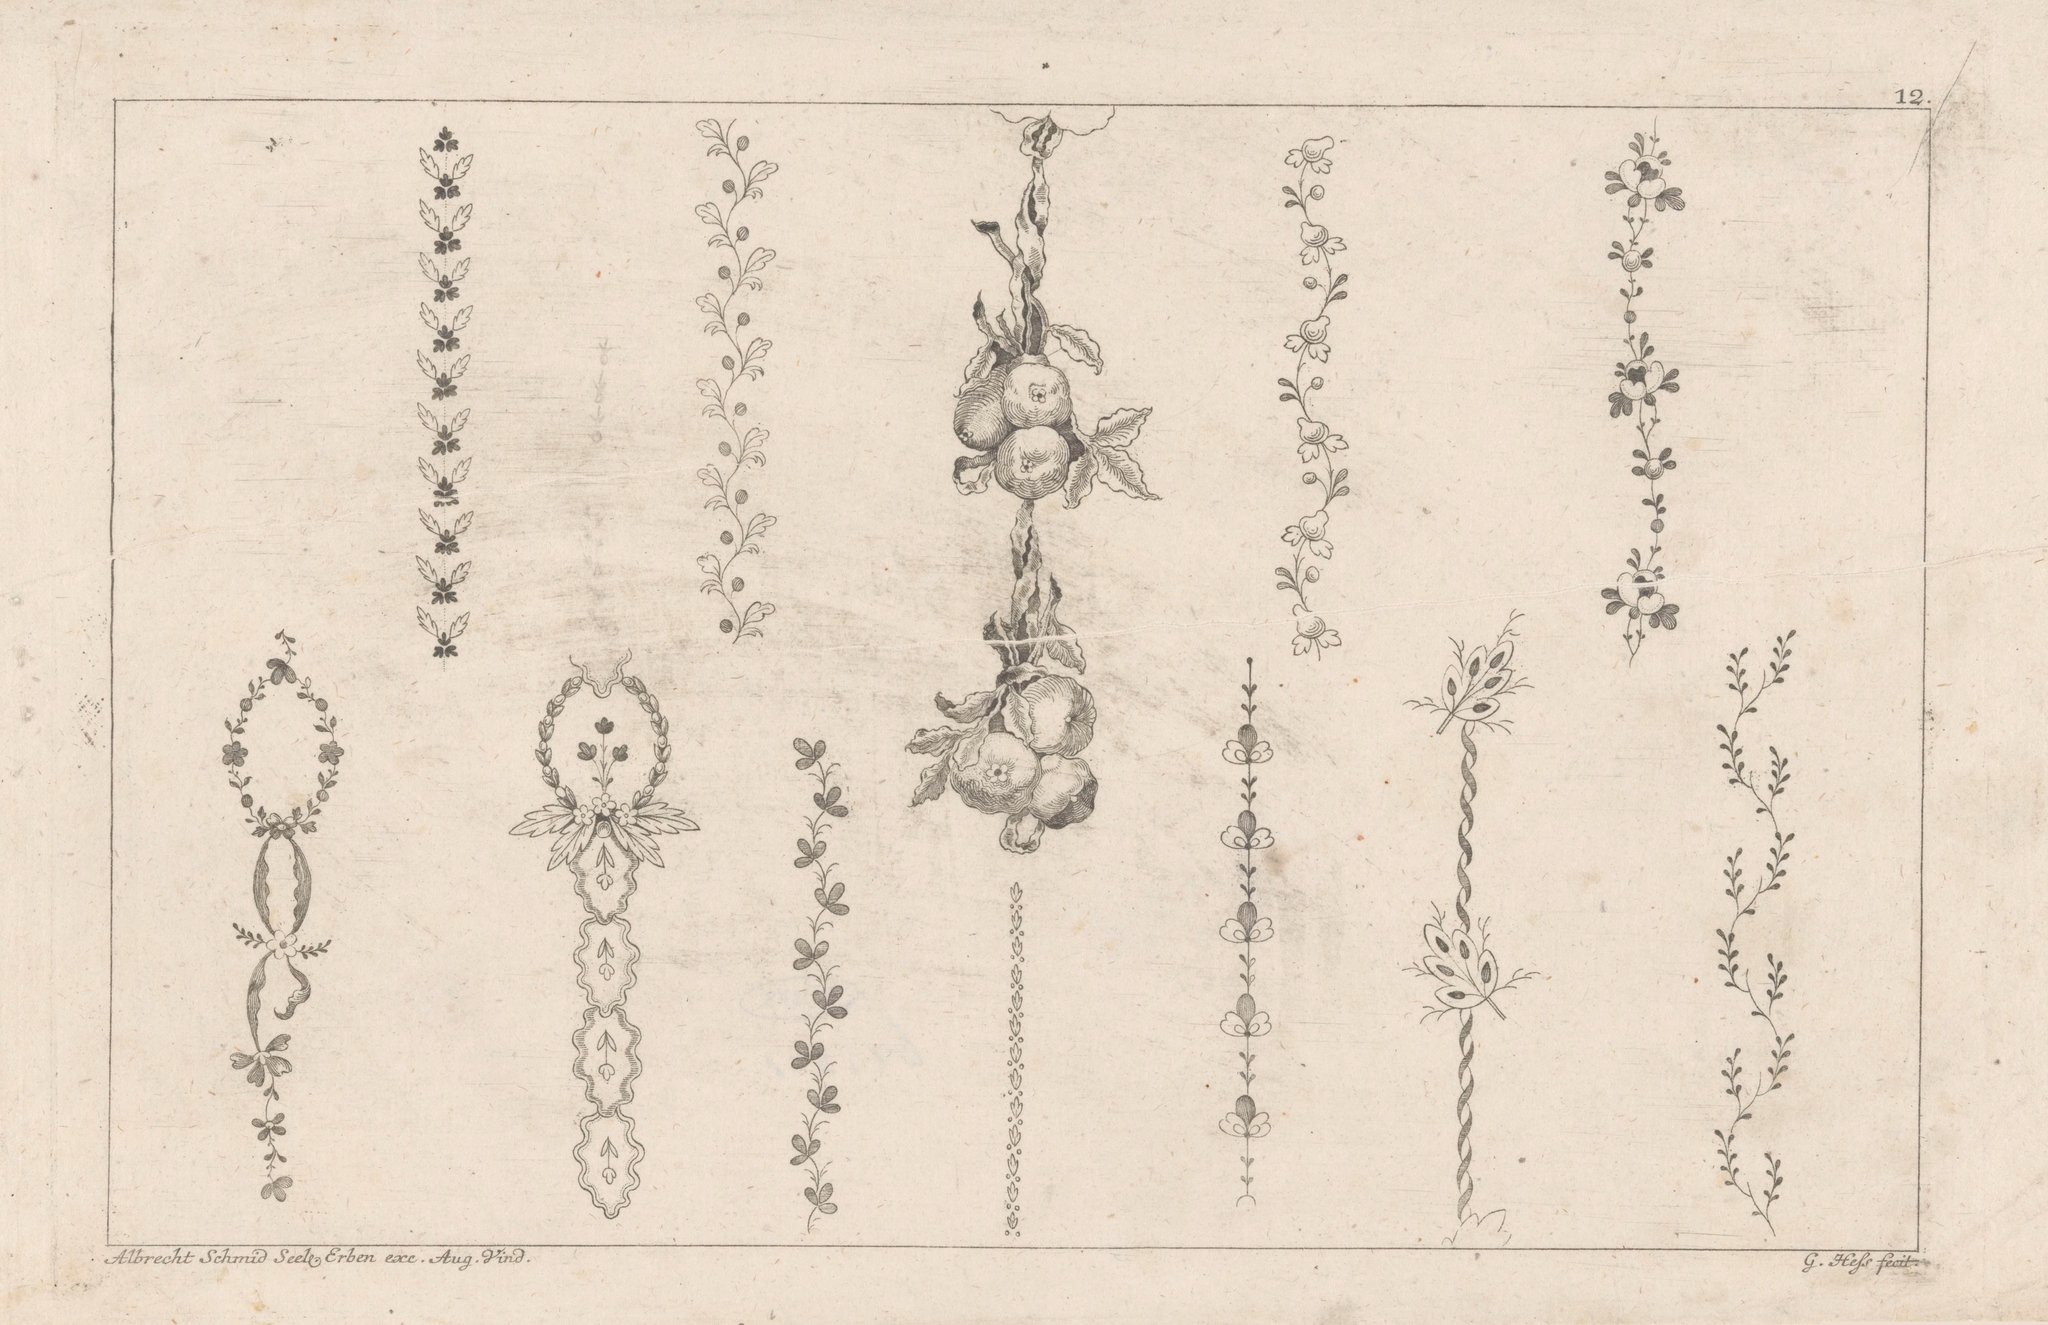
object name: print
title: 2. Theil. Allerlei Bouquets Blumen und Streifen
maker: gottlieb hess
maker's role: publisher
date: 1744-1800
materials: paper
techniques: etching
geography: augsburg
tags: fruits and vegetables ~ ornament, foliage, tendrils, branches ~ ornament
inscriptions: collector's mark: Lugt 2228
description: Ontwerpen voor diverse bloemenranken. In het midden twee ranken met vruchten.